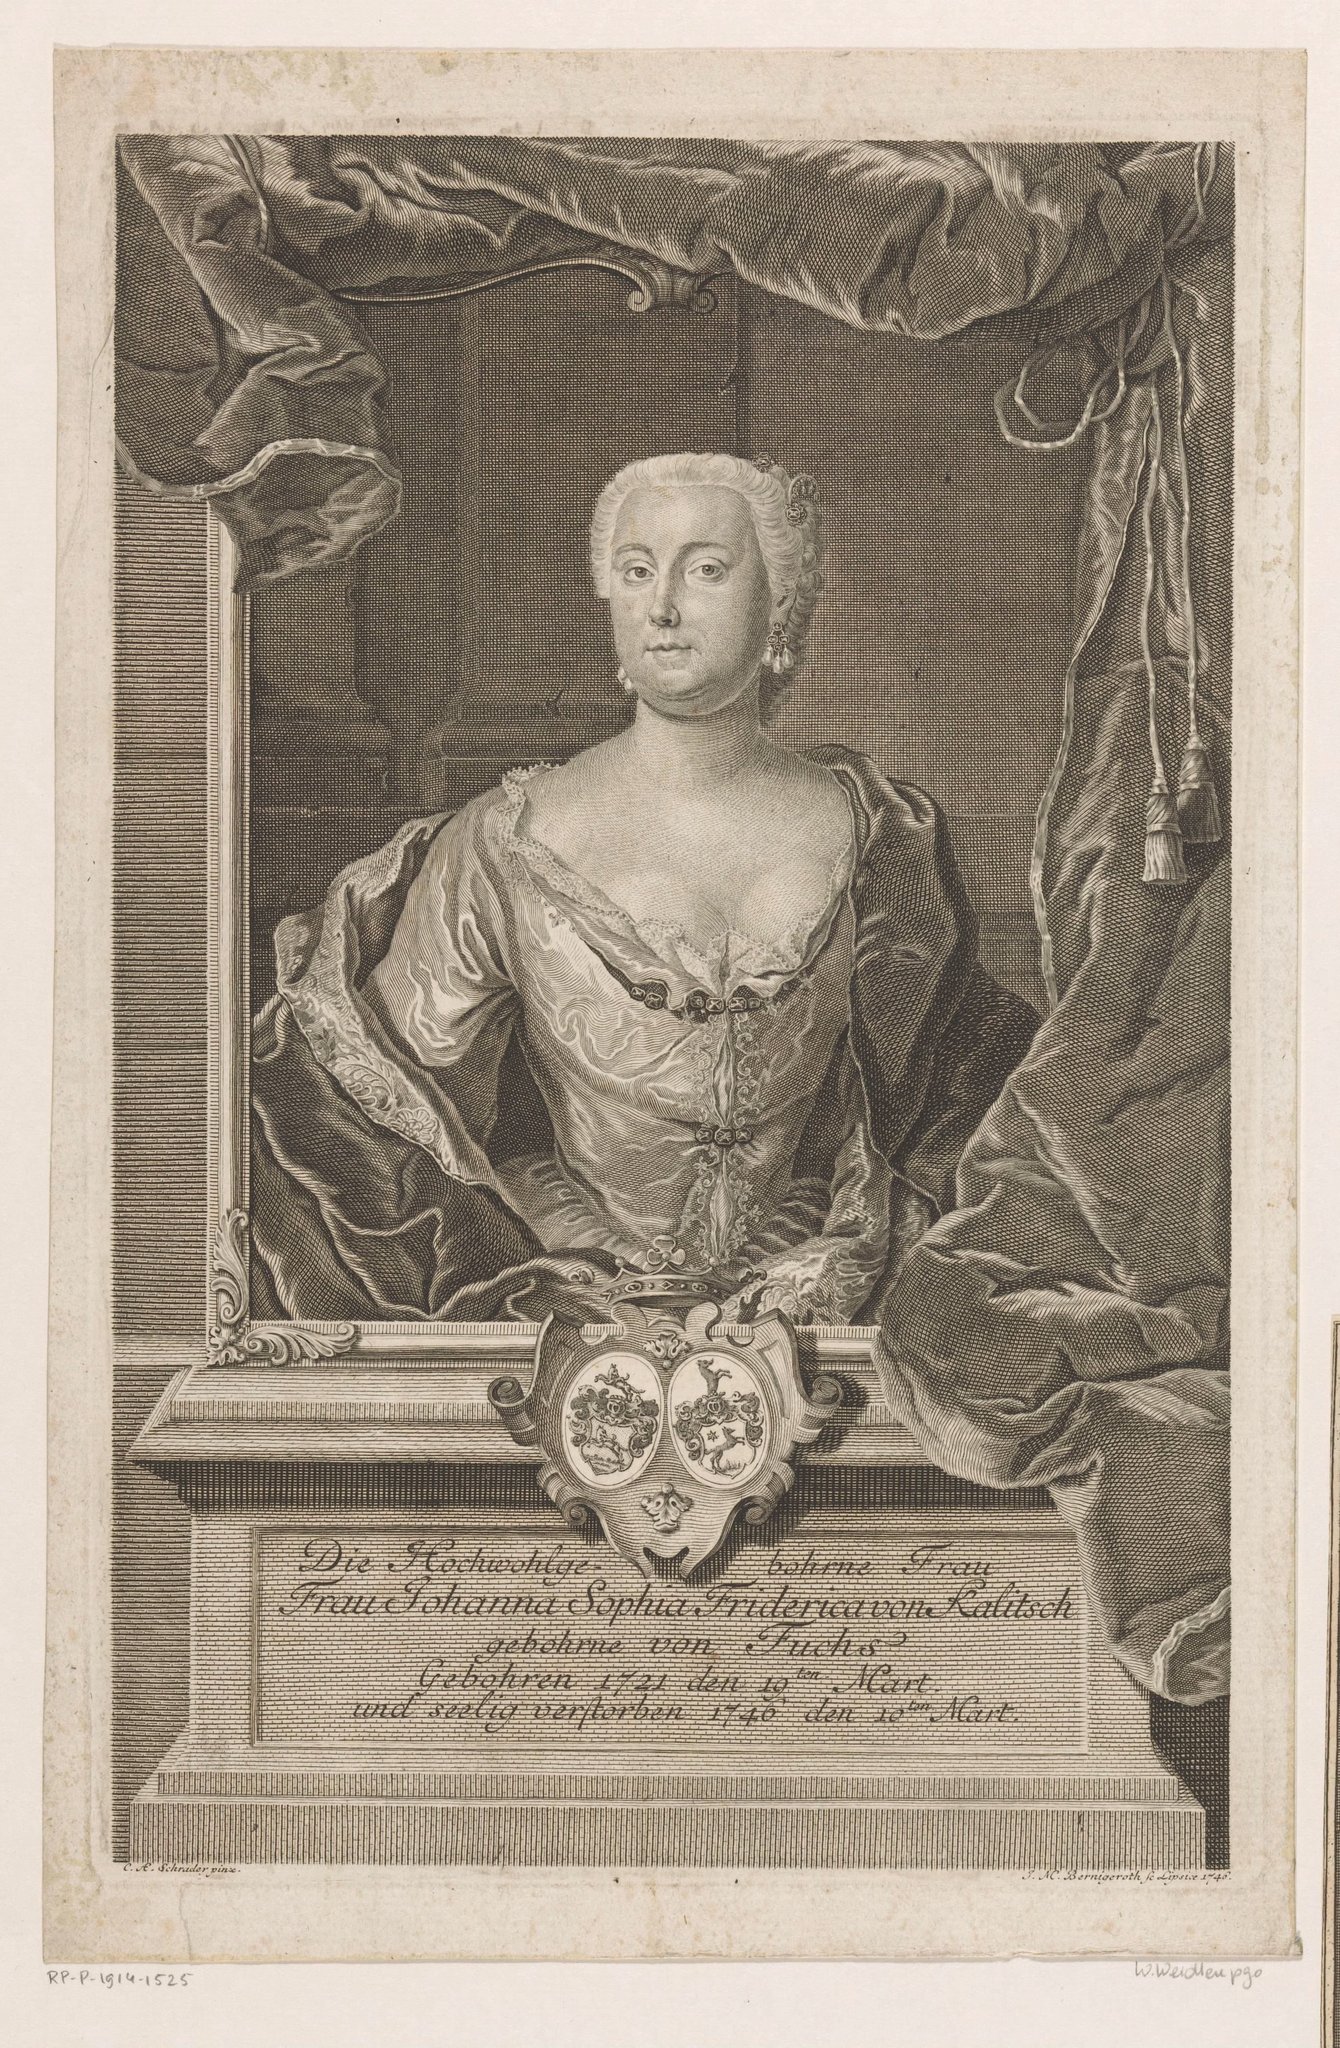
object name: print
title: Portret van Johanna Sophia Friederika von Kalitsch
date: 1746-1767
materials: paper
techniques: engraving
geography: leipzig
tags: historical persons - bb - woman, armorial bearing, heraldry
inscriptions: collector's mark: Lugt 2228